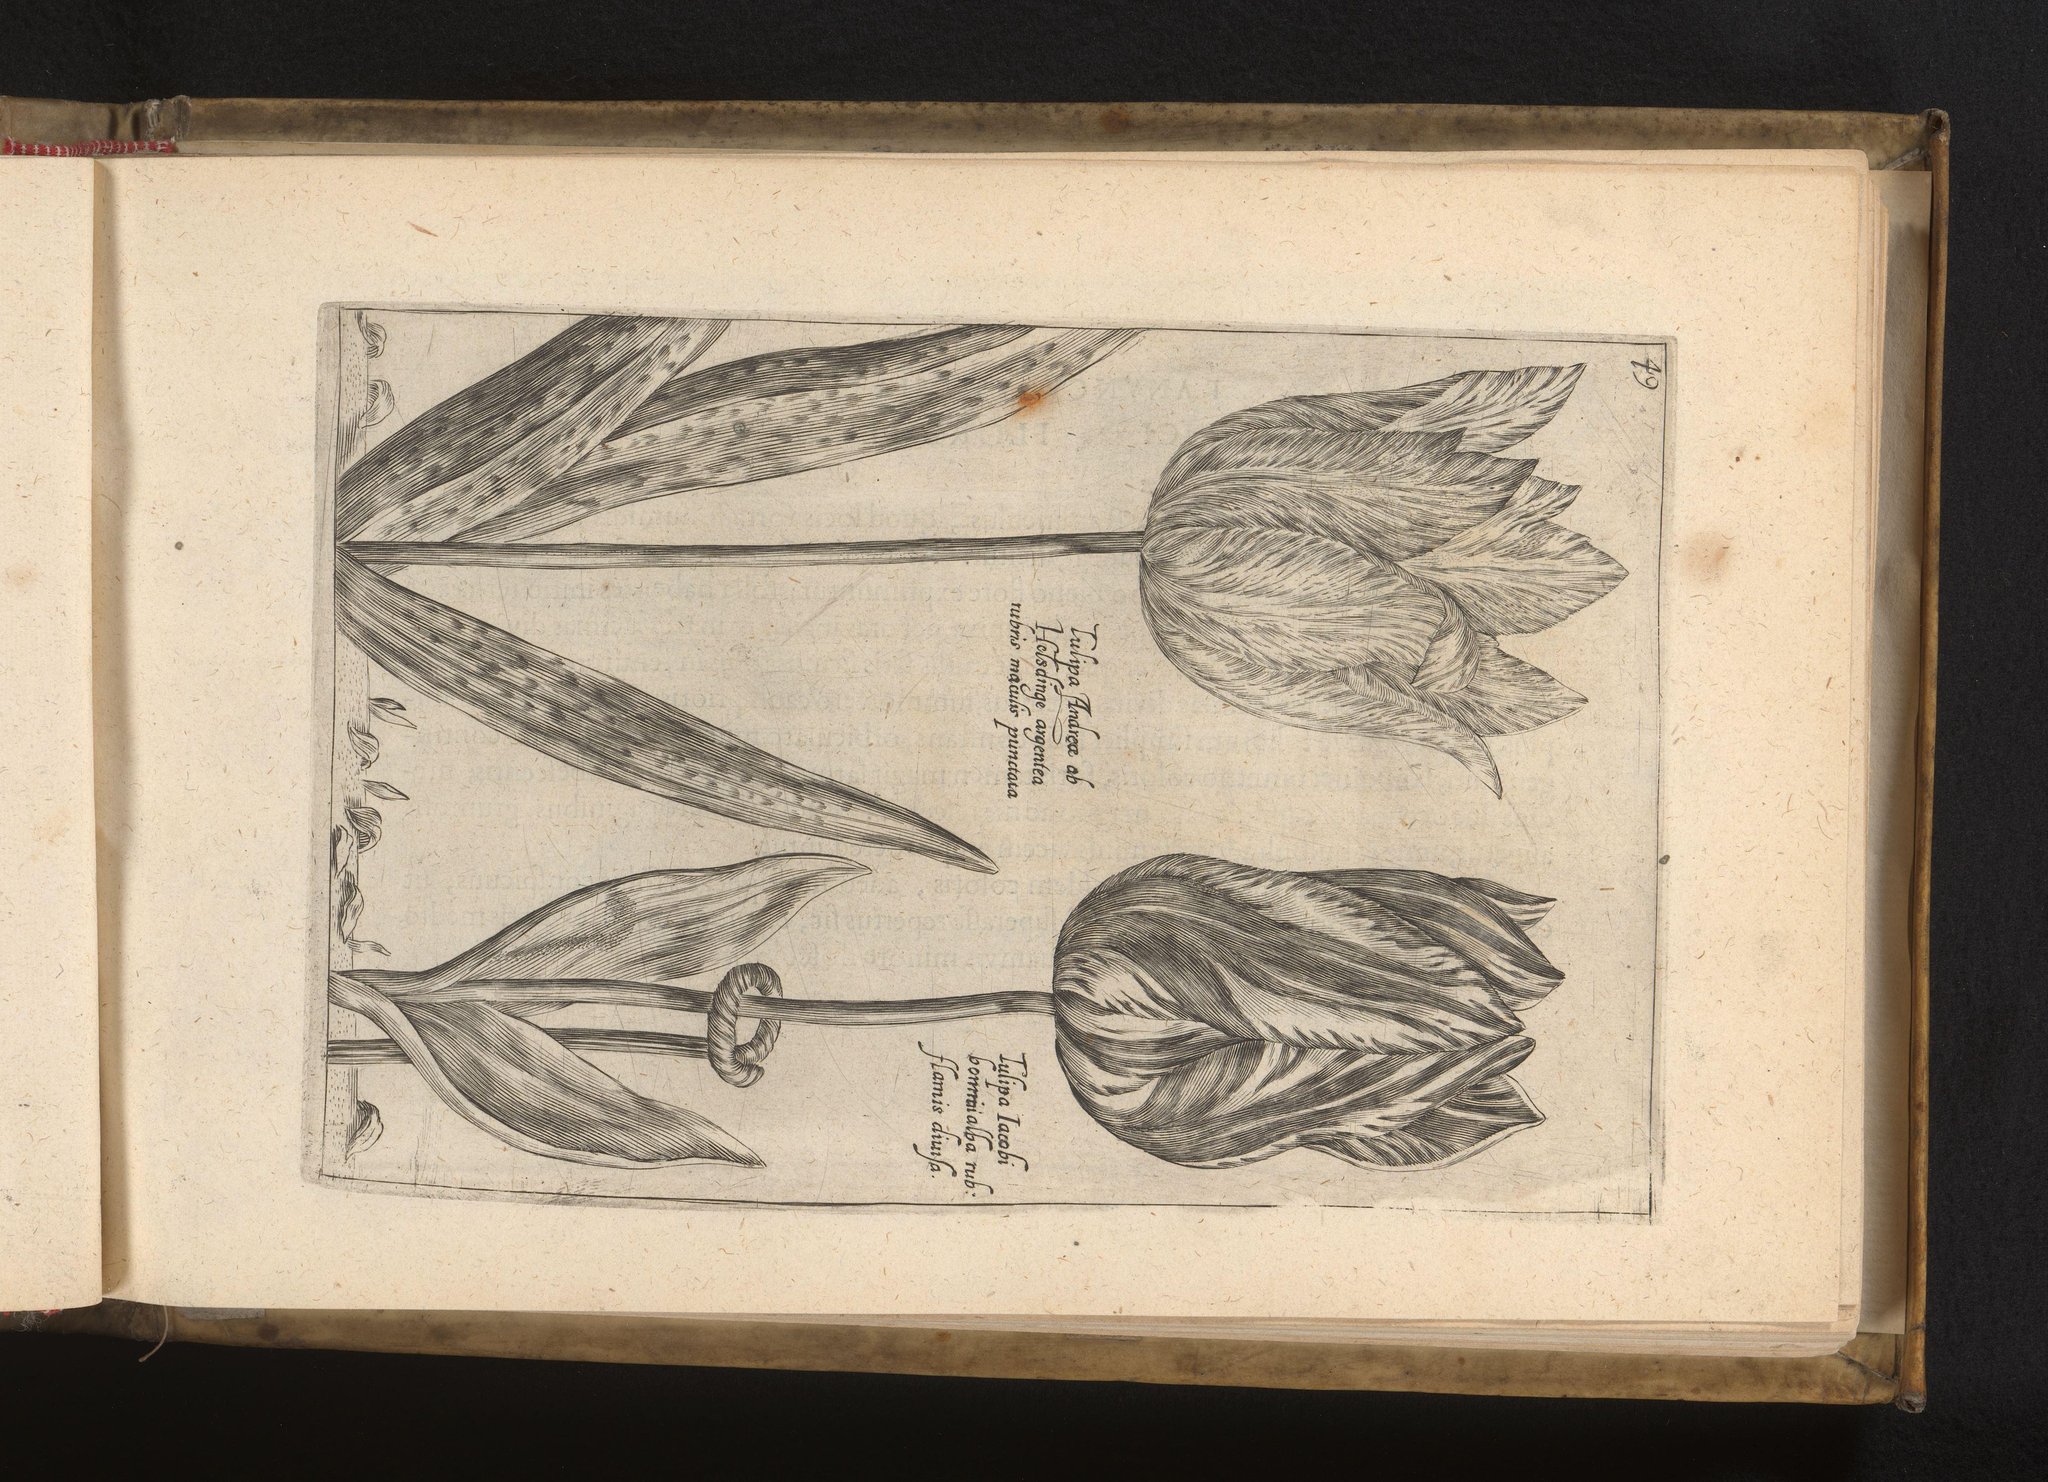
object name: book illustration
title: Bloemtuin van de lente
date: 1617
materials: paper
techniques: engraving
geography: utrecht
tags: flowers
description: Prent uit: Passe, Crispijn van de (II). Hortus floridus in quo rariorum & minus vulgarium florum icones ad vivam veramque formam. Arnhem: Johannes Janssonius, 1617.